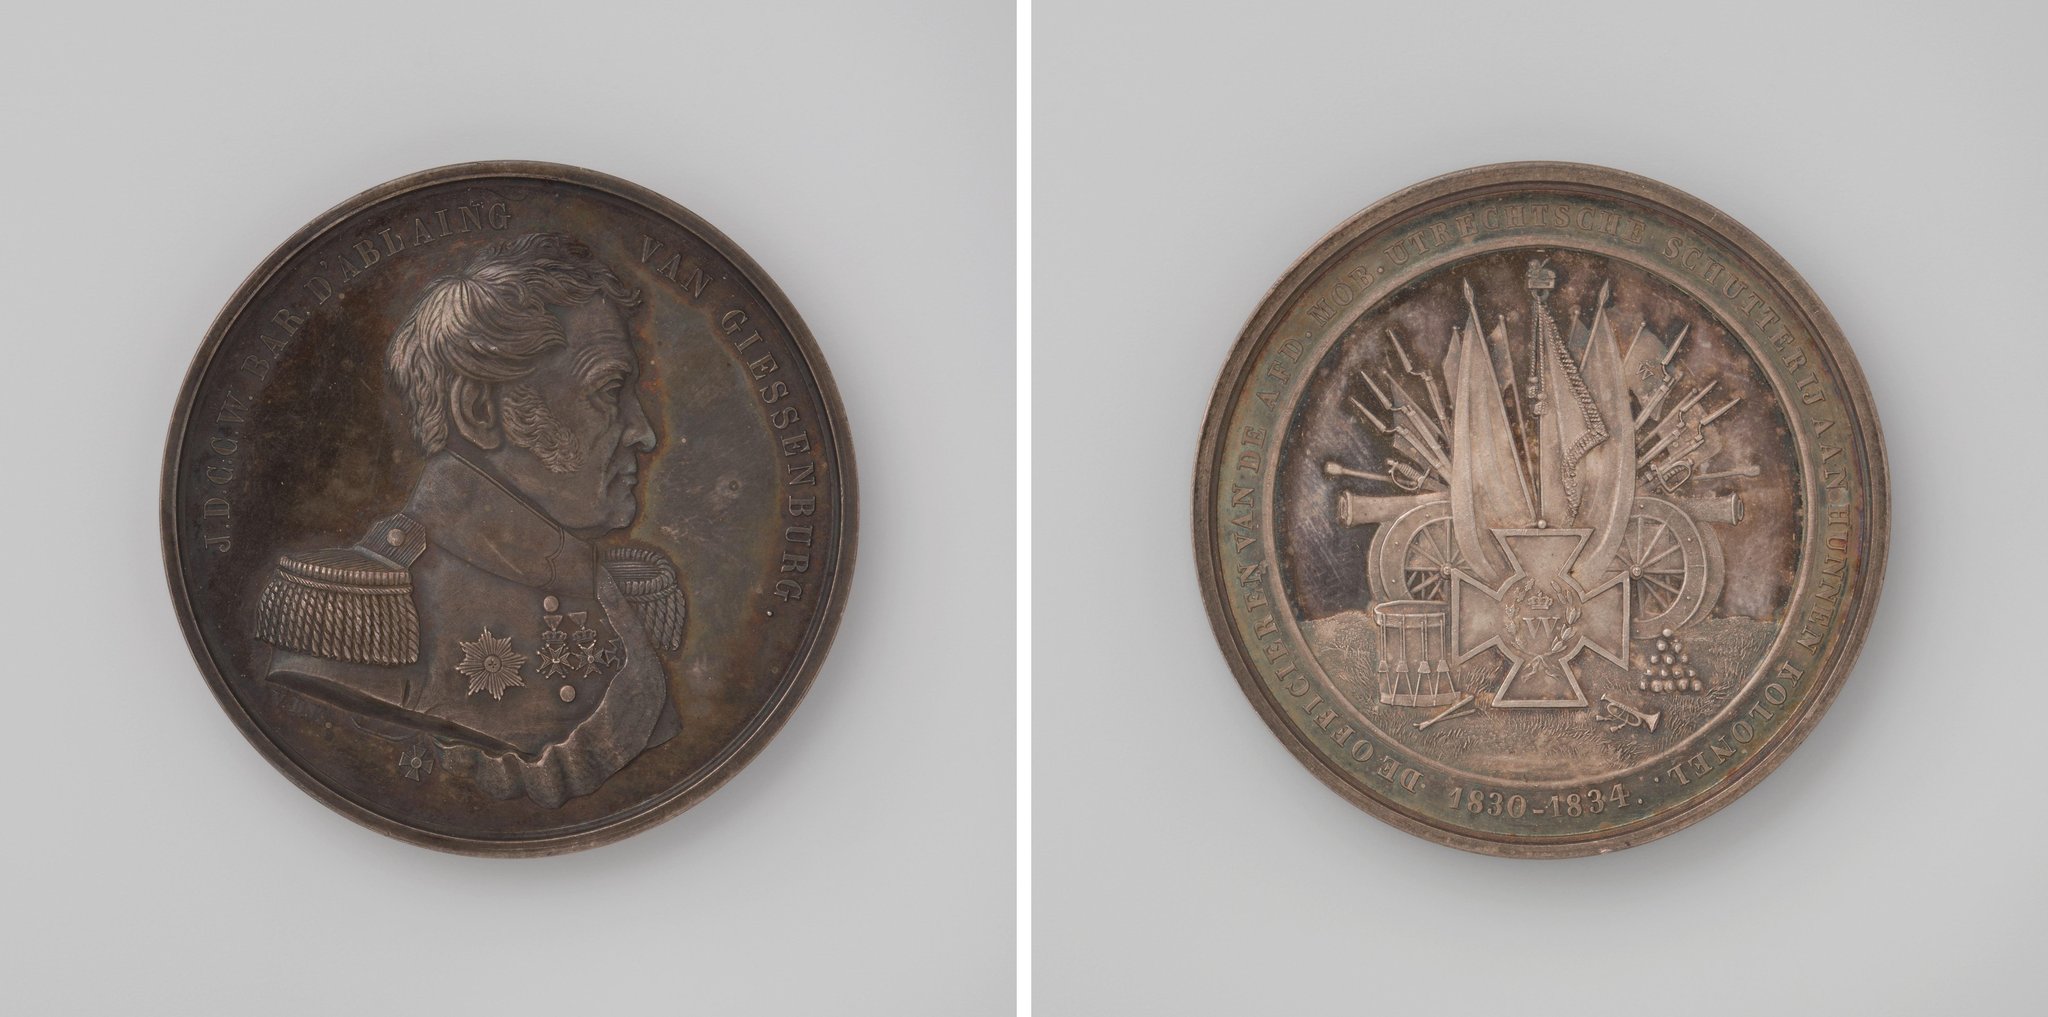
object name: honorary medal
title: Joan Daniel Cornelis Carel Willem, baron d'Ablaing van Giessenburg, penning door de officieren van de afdeling Mobiele Utrechtse Schutterij aan hun kolonel geschonken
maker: david van der kellen (1804-1879)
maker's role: die cutter, draughtsman, print maker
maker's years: 1804-1879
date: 1853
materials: silver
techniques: striking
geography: utrecht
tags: politician, utrecht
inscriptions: circumscription: ‘J.D.C.C.W. Bar. d'Ablaing van Giessenburg’, circumscription: ‘De officieren van de afd. mob. Utrechtsche schutterij aan hunnen kolonel. 1830-1834’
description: Zilveren penning. Voorzijde: borststuk man in uniform met decoraties, in profiel naar rechts gezien binnen omschrift. Keerzijde: wapentrophee, waartegen Metalen Kruis is geplaatst binnen omschrift.